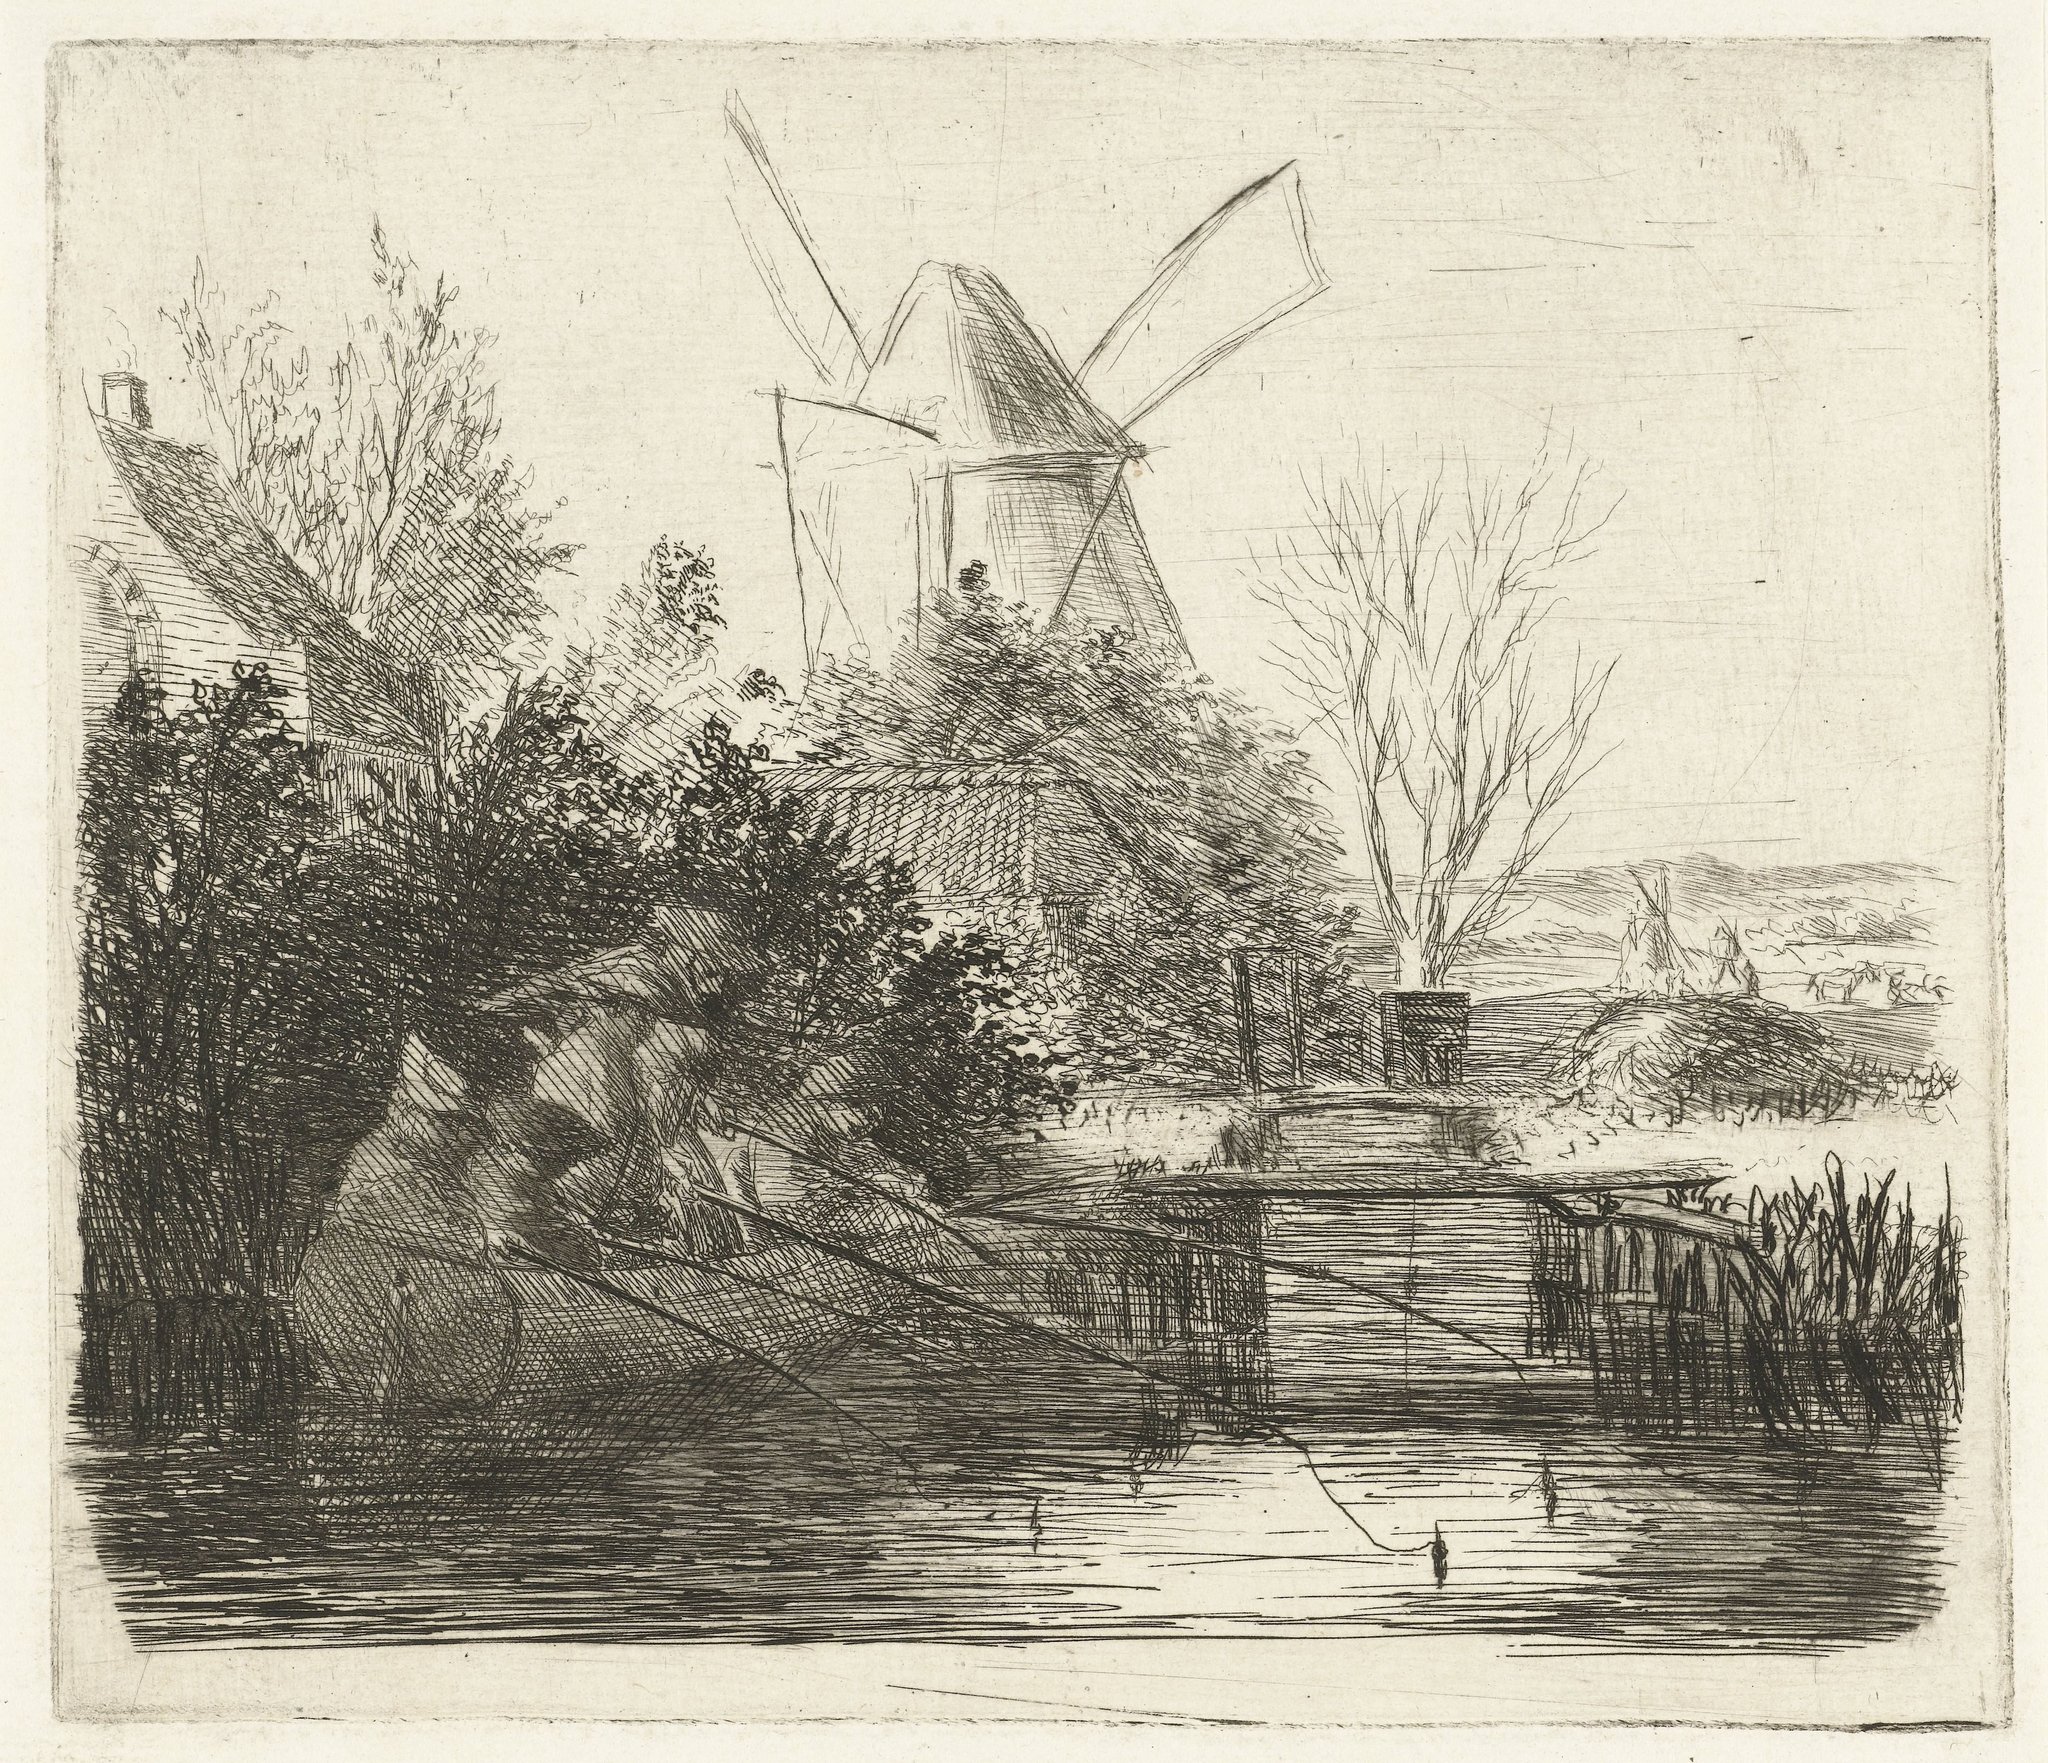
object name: print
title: Hengelaars bij een rivier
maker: louis bernard coclers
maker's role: draughtsman, print maker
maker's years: 1741-1817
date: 1756-1817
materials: paper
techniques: drypoint, etching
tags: fresh-water fishery, rowing-boat, canoe, etc.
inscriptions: collector's mark: Lugt 2228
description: Een groepje mannen vist vanuit een bootje in een rivier. Op de achtergrond een brug en de omtrek van een molen.